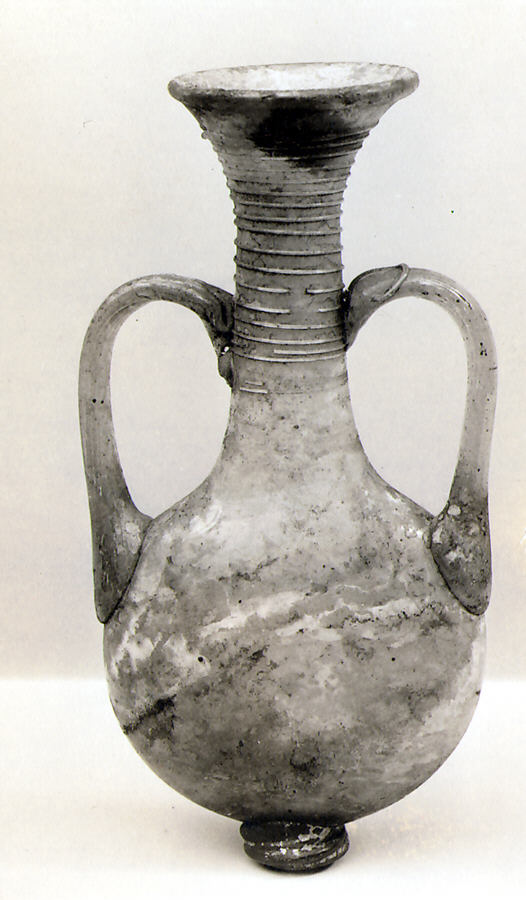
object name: flask, lentoid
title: Glass lentoid flask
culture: roman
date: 301-500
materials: glass